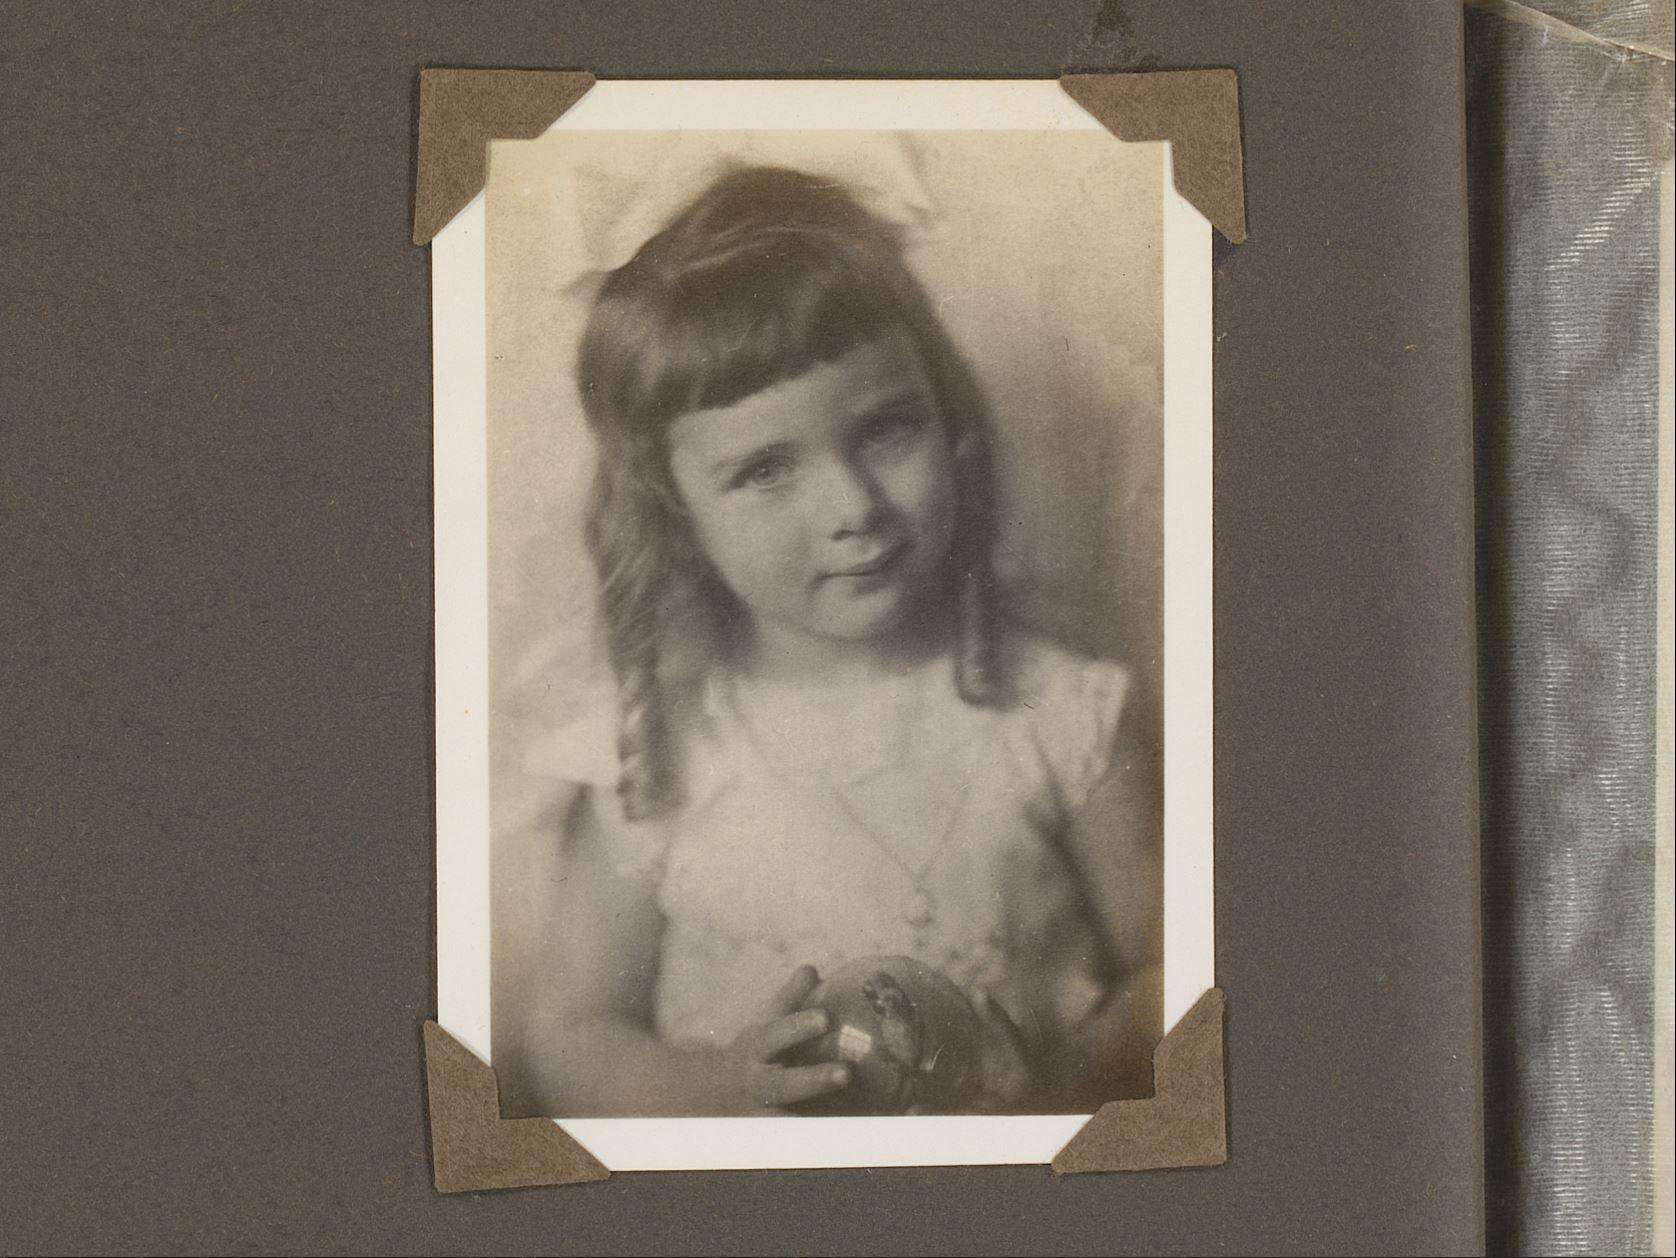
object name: photograph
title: Portret van een meisje met pijpenkrullen en een strik in het haar en een bal in haar handen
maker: Anonymous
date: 1920-1940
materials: photographic support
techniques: gelatin silver print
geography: netherlands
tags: historical persons, girl (child between toddler and youth)